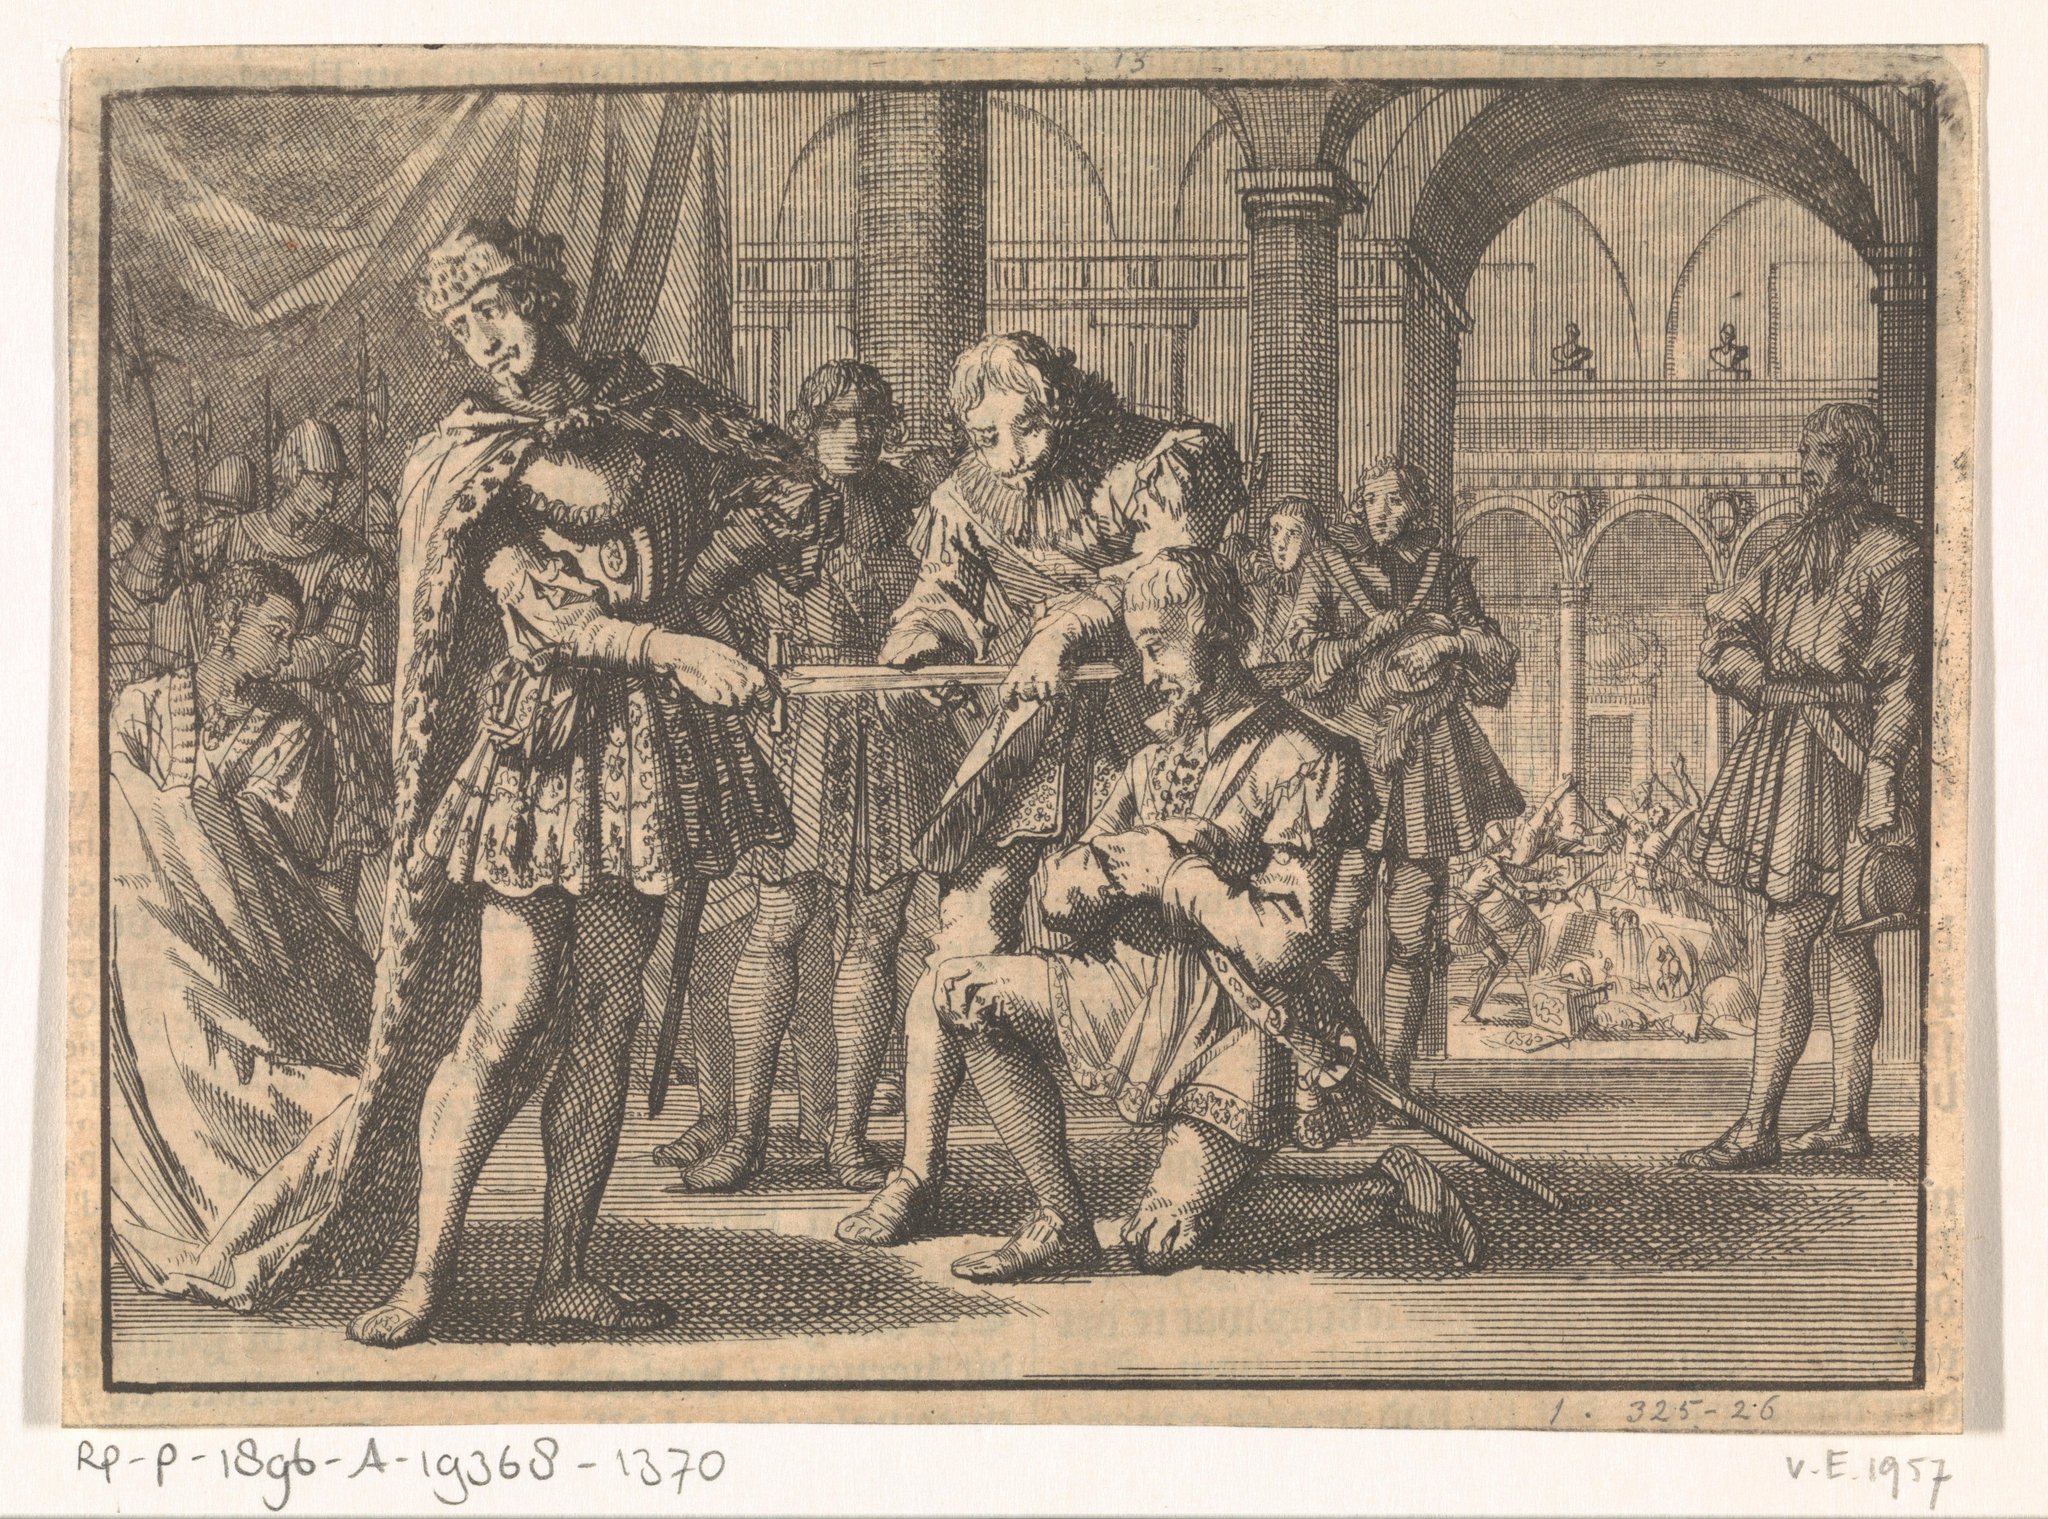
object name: book illustration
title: Vrees van Jacobus I, koning van Engeland, voor een zwaard bij het ridderen van Kenelm Digby, ca. 1623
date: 1698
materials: paper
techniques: etching, letterpress printing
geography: leiden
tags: london, physicist, jacobus i (koning van engeland), knighting ceremonies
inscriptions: collector's mark: Lugt 2228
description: Illustratie uit: Gottfried, Johann Ludwig. Historische kronyck; vervattende een (...) beschrijvingh der aldergedenckwaerdigste geschiedenissen des weerelds, van den aenvangh der scheppingh tot (...) 1576 (2 delen). Leiden: Pieter van der Aa, 1698, dl. I, p. 325.